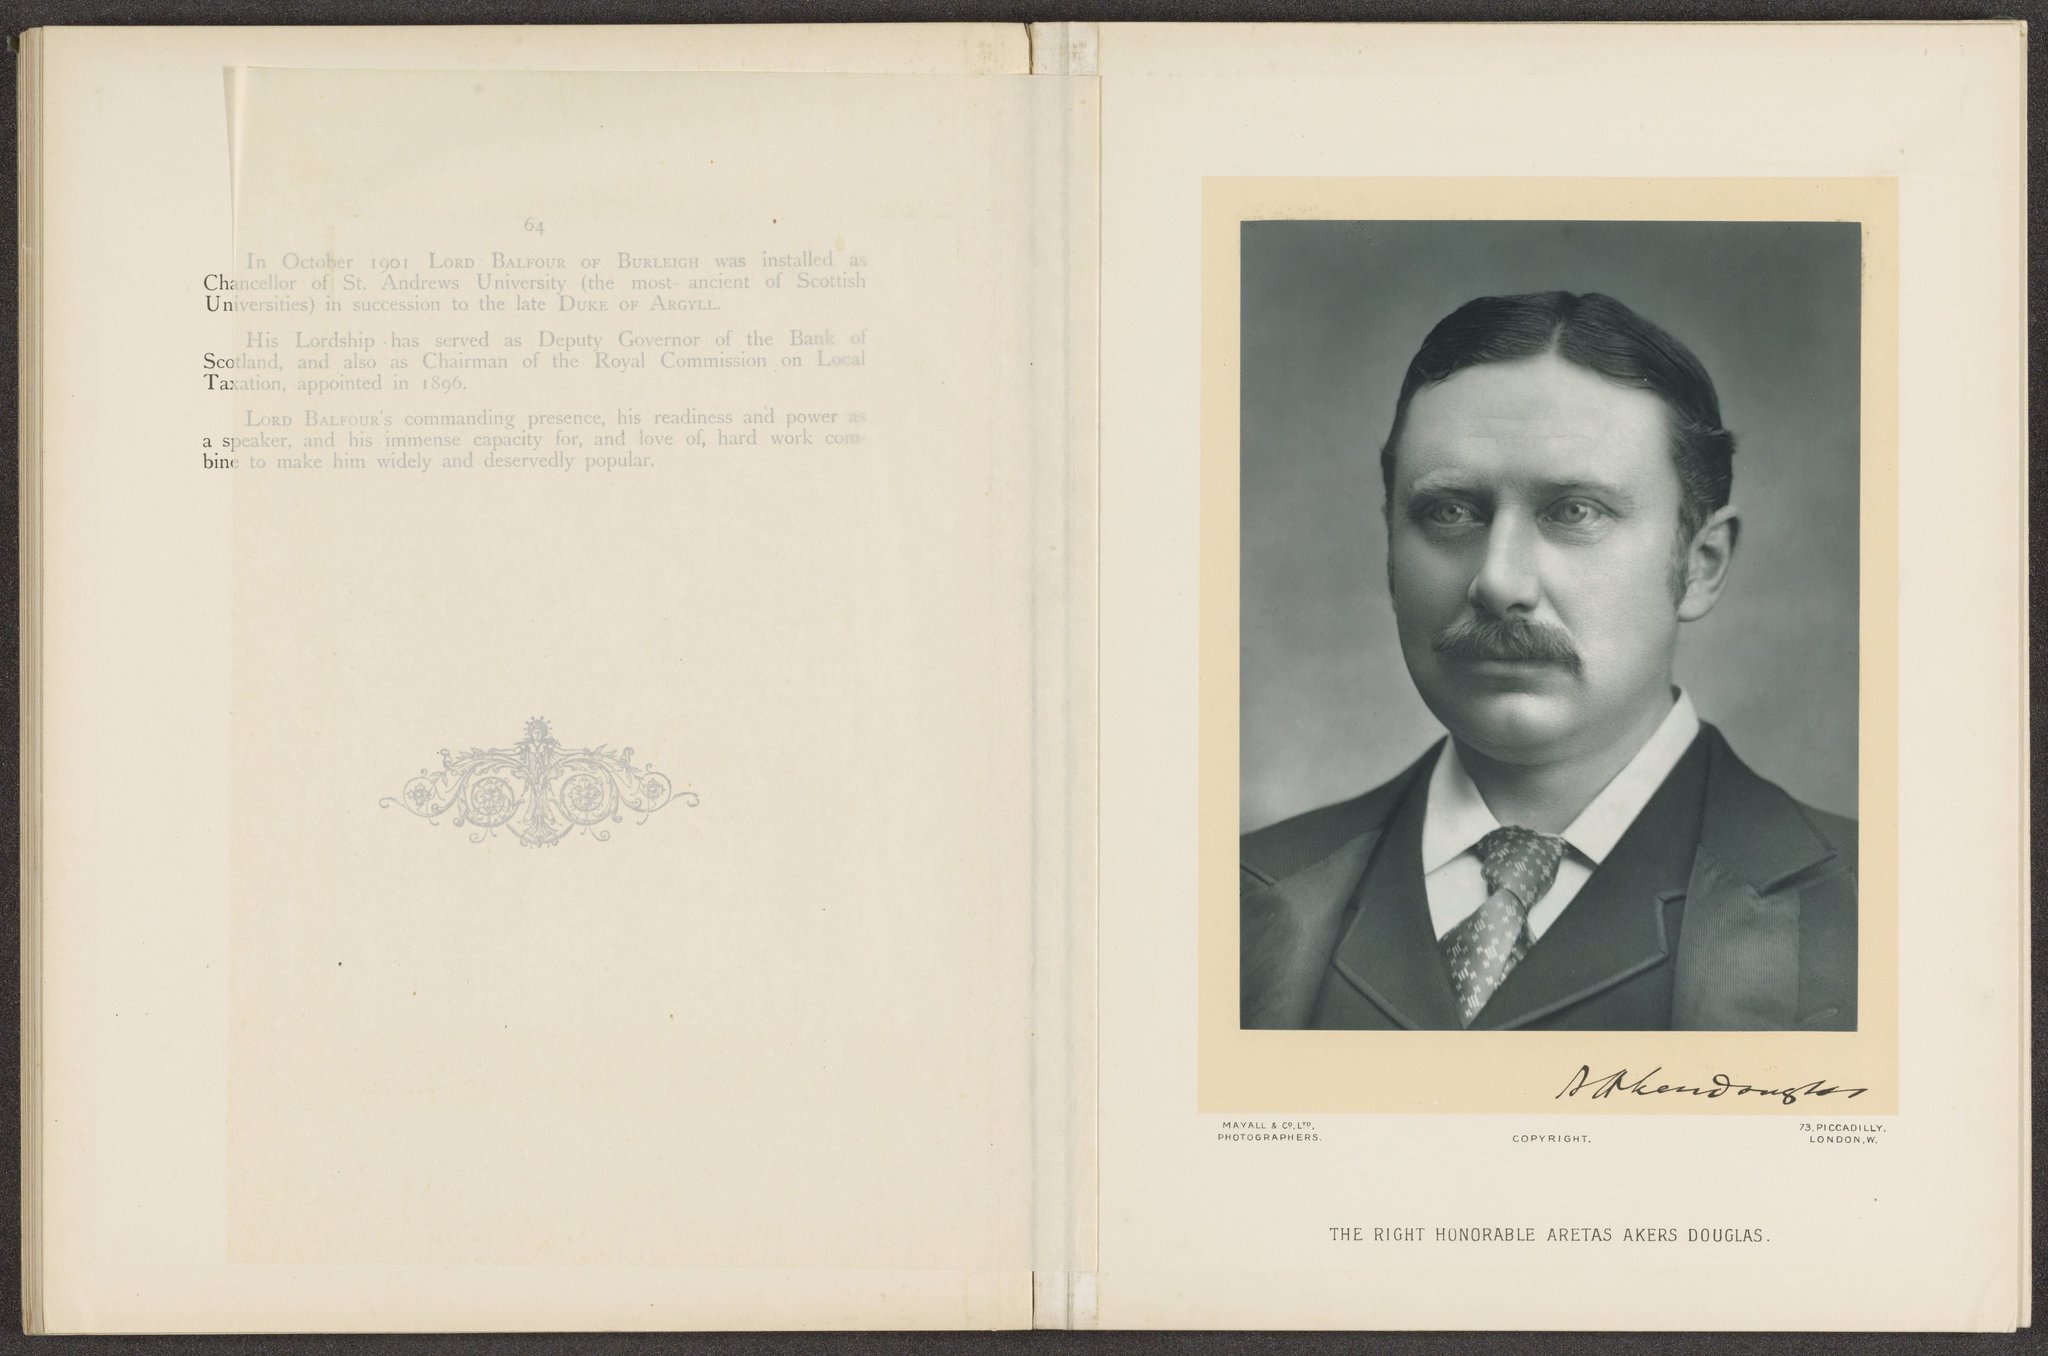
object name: page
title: The right honorable Aretas Akers Douglas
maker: john jabez edwin mayall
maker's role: fotograaf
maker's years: 1813-1901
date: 1893-1903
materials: paper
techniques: carbon print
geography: london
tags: politician, historical persons (portraits and scenes from the life) (+ (full) bust portrait)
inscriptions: annotation, inscription: ‘73, Piccadilly, London, W.’